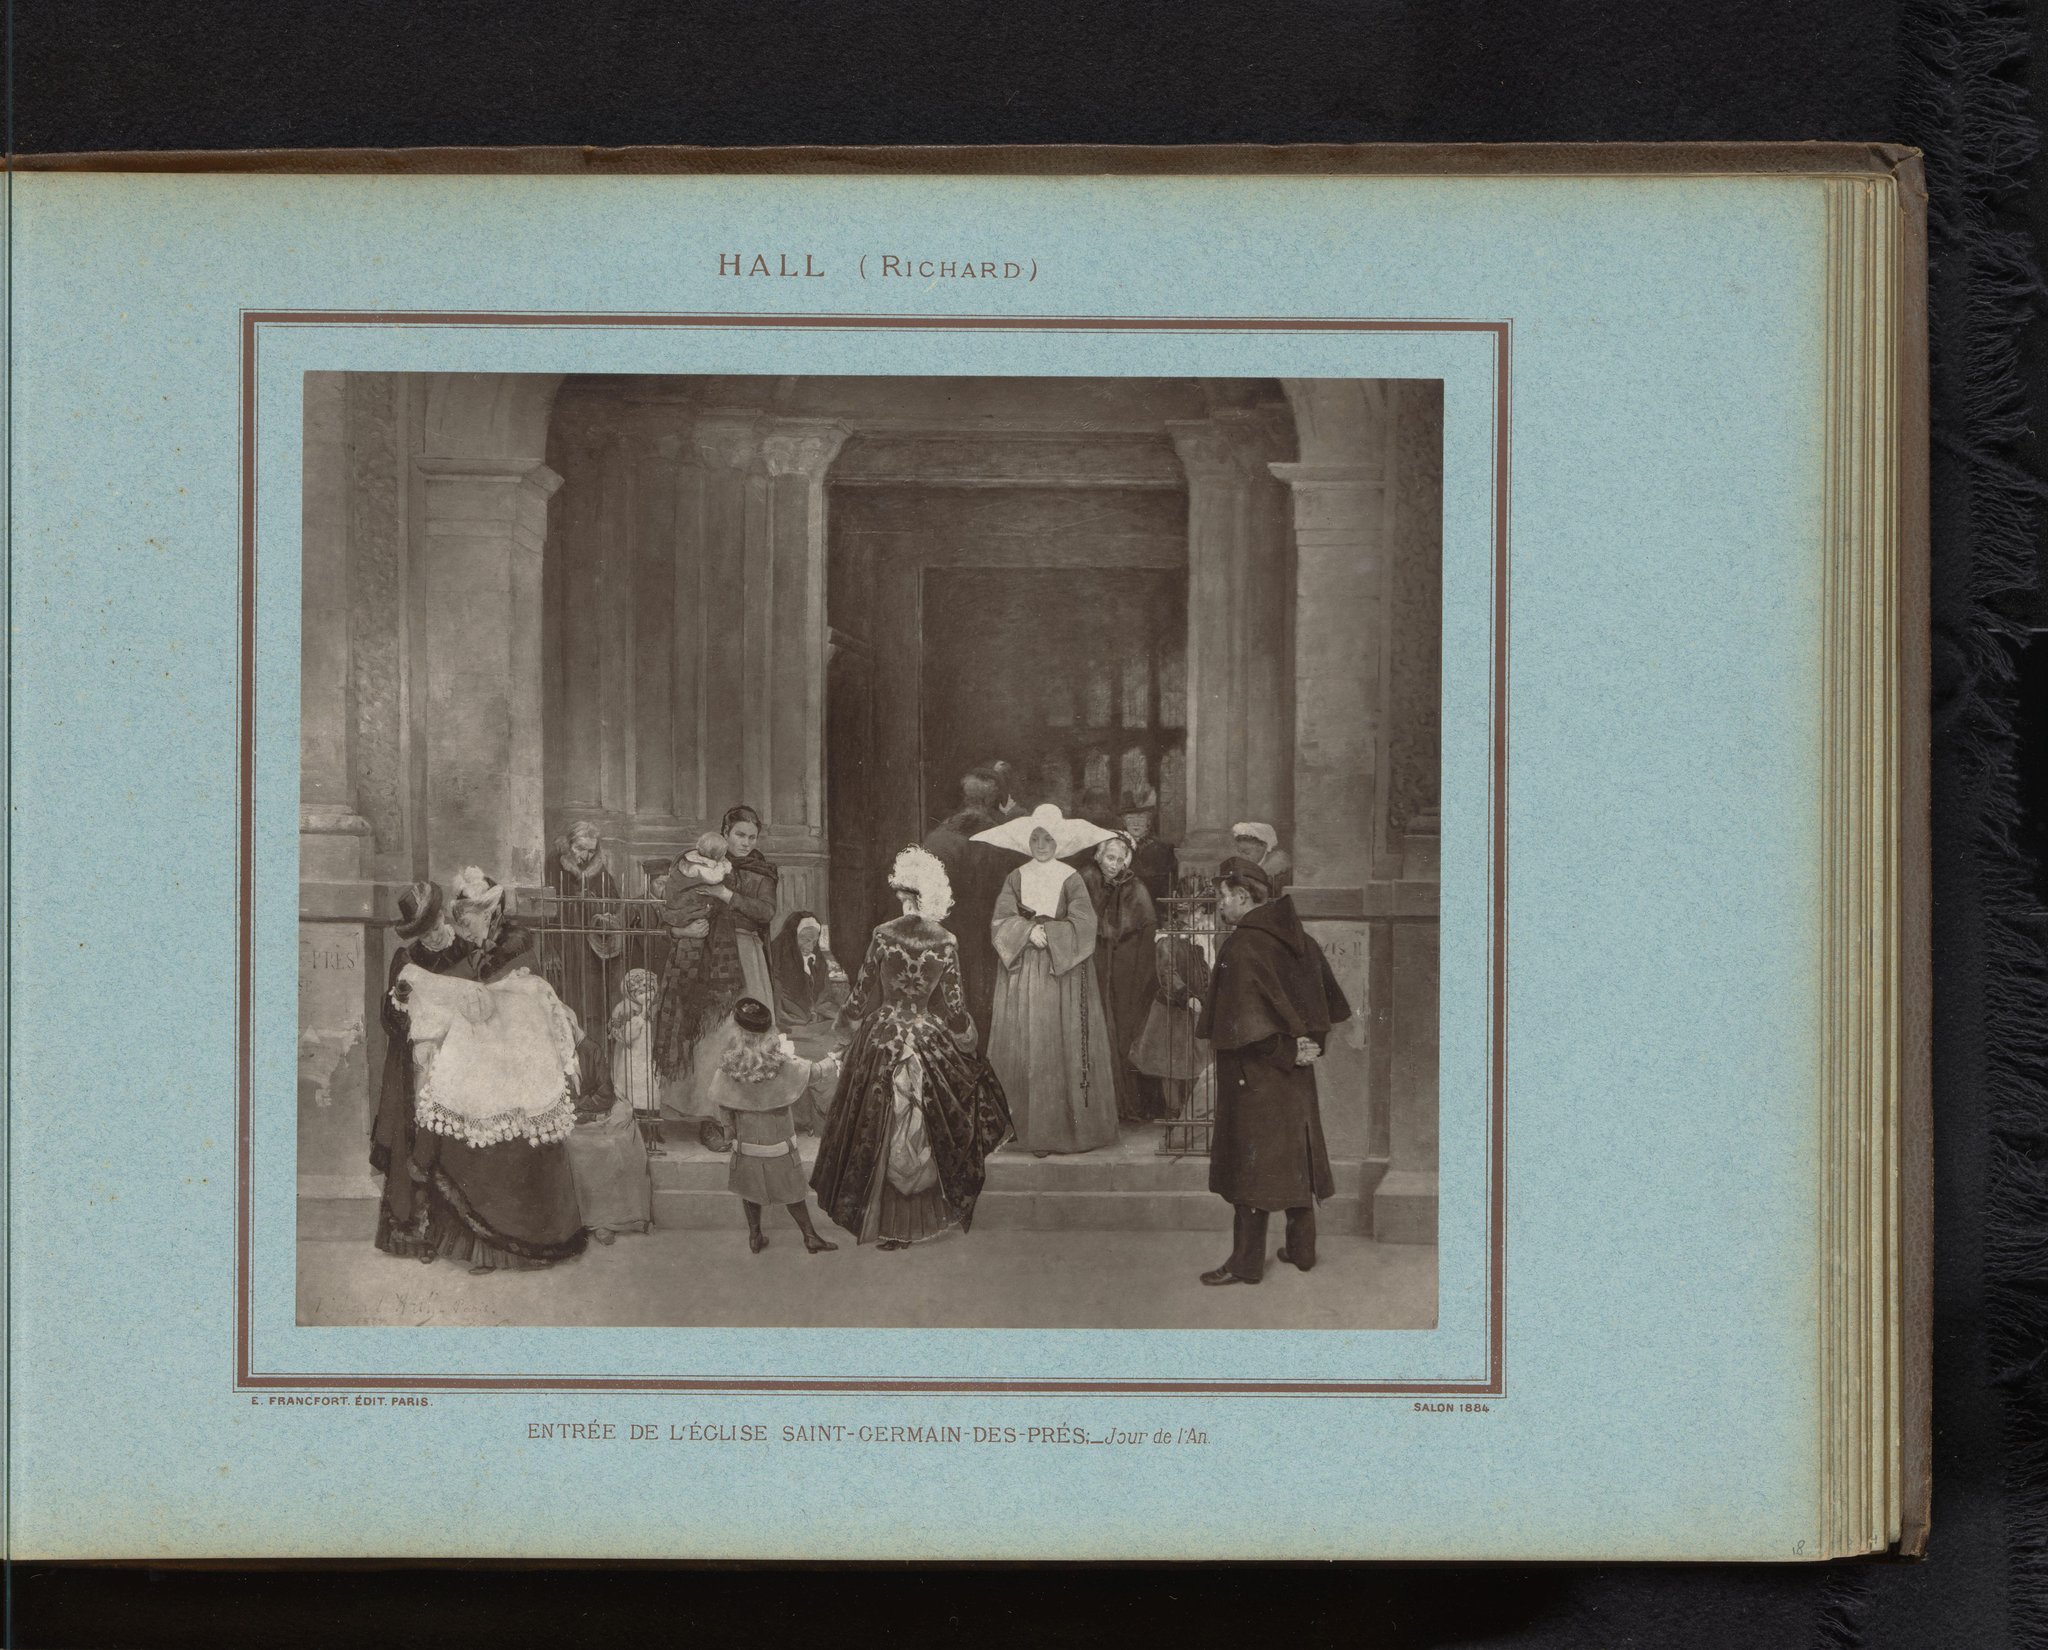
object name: photomechanical print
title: Entrée de l'Église Saint-Germain-des-Prés; Jour de l'An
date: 1884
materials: paper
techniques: woodburytype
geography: paris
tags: going to church, church (exterior)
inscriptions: name: ‘HALL (Richard)’, inscription: ‘SALON 1884.’